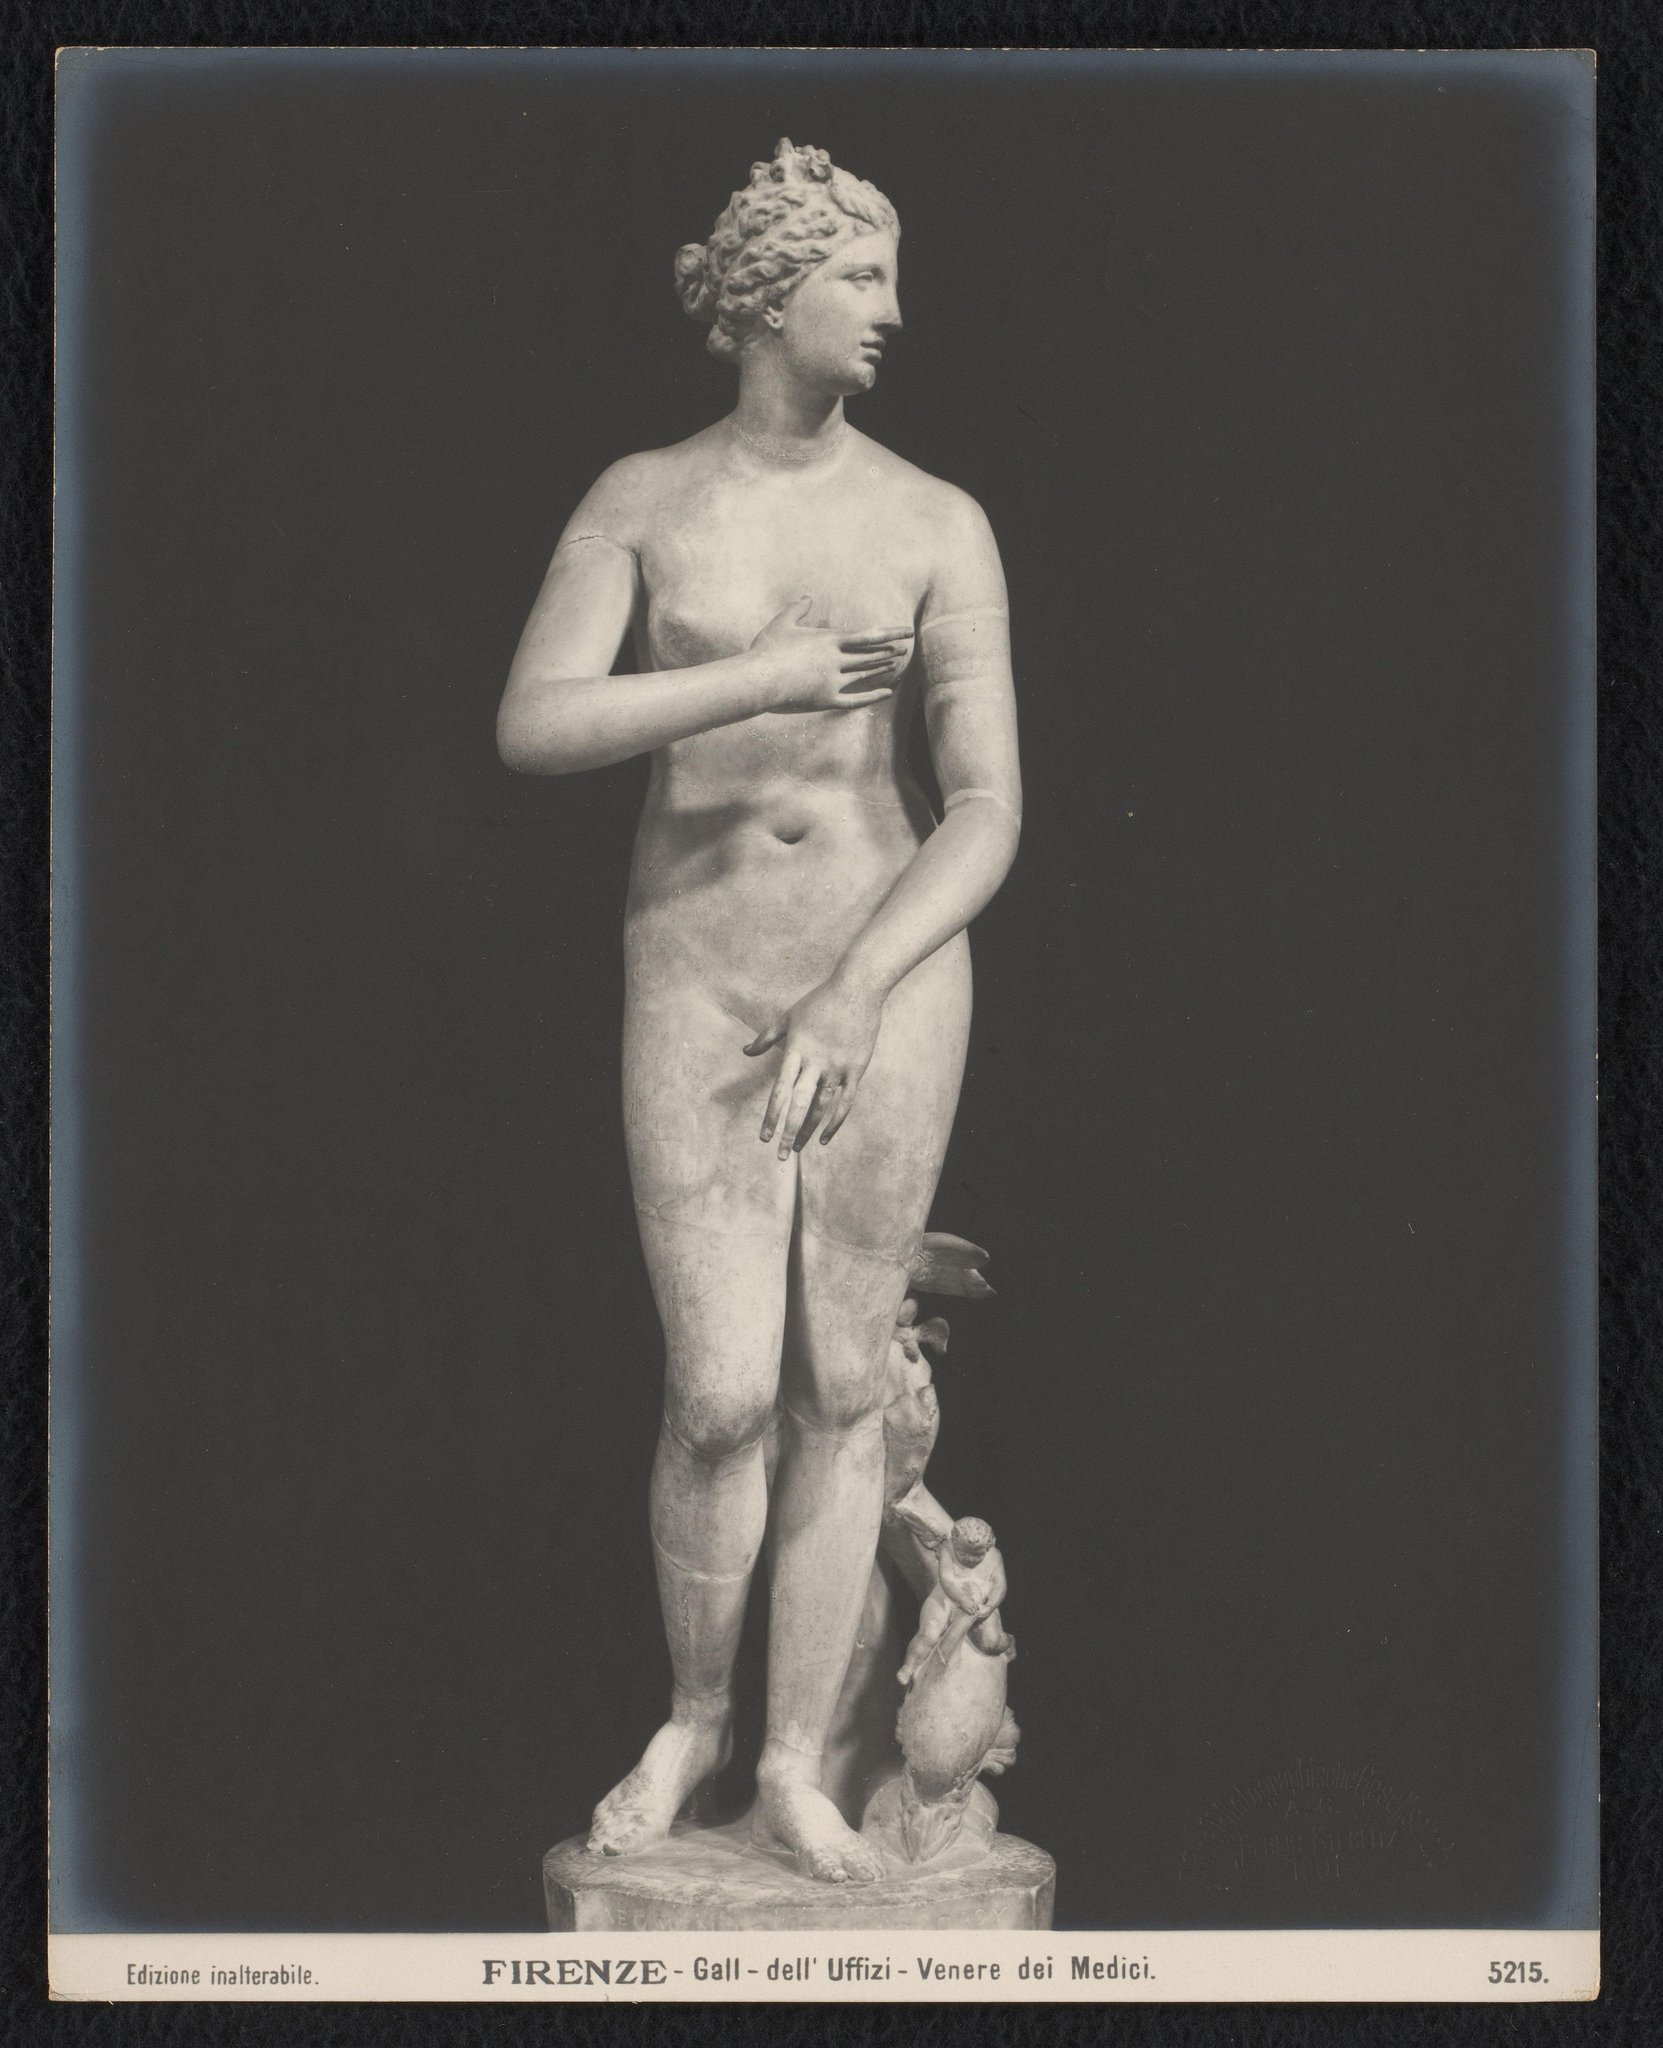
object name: photograph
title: Gall - dell'Uffizi - Venere dei Medici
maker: Anonymous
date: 1901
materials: paper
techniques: gelatin silver print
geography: florence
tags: piece of sculpture, reproduction of a piece of sculpture, (story of) venus (aphrodite)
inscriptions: number: ‘5215.’, inscription: ‘Edizione inalterabile.’, collector's mark: ‘RIJKS SCHOOL VOOR KUNSTNIJVERHEID/ GROEP’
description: Deze foto maakt deel uit van een omslag.